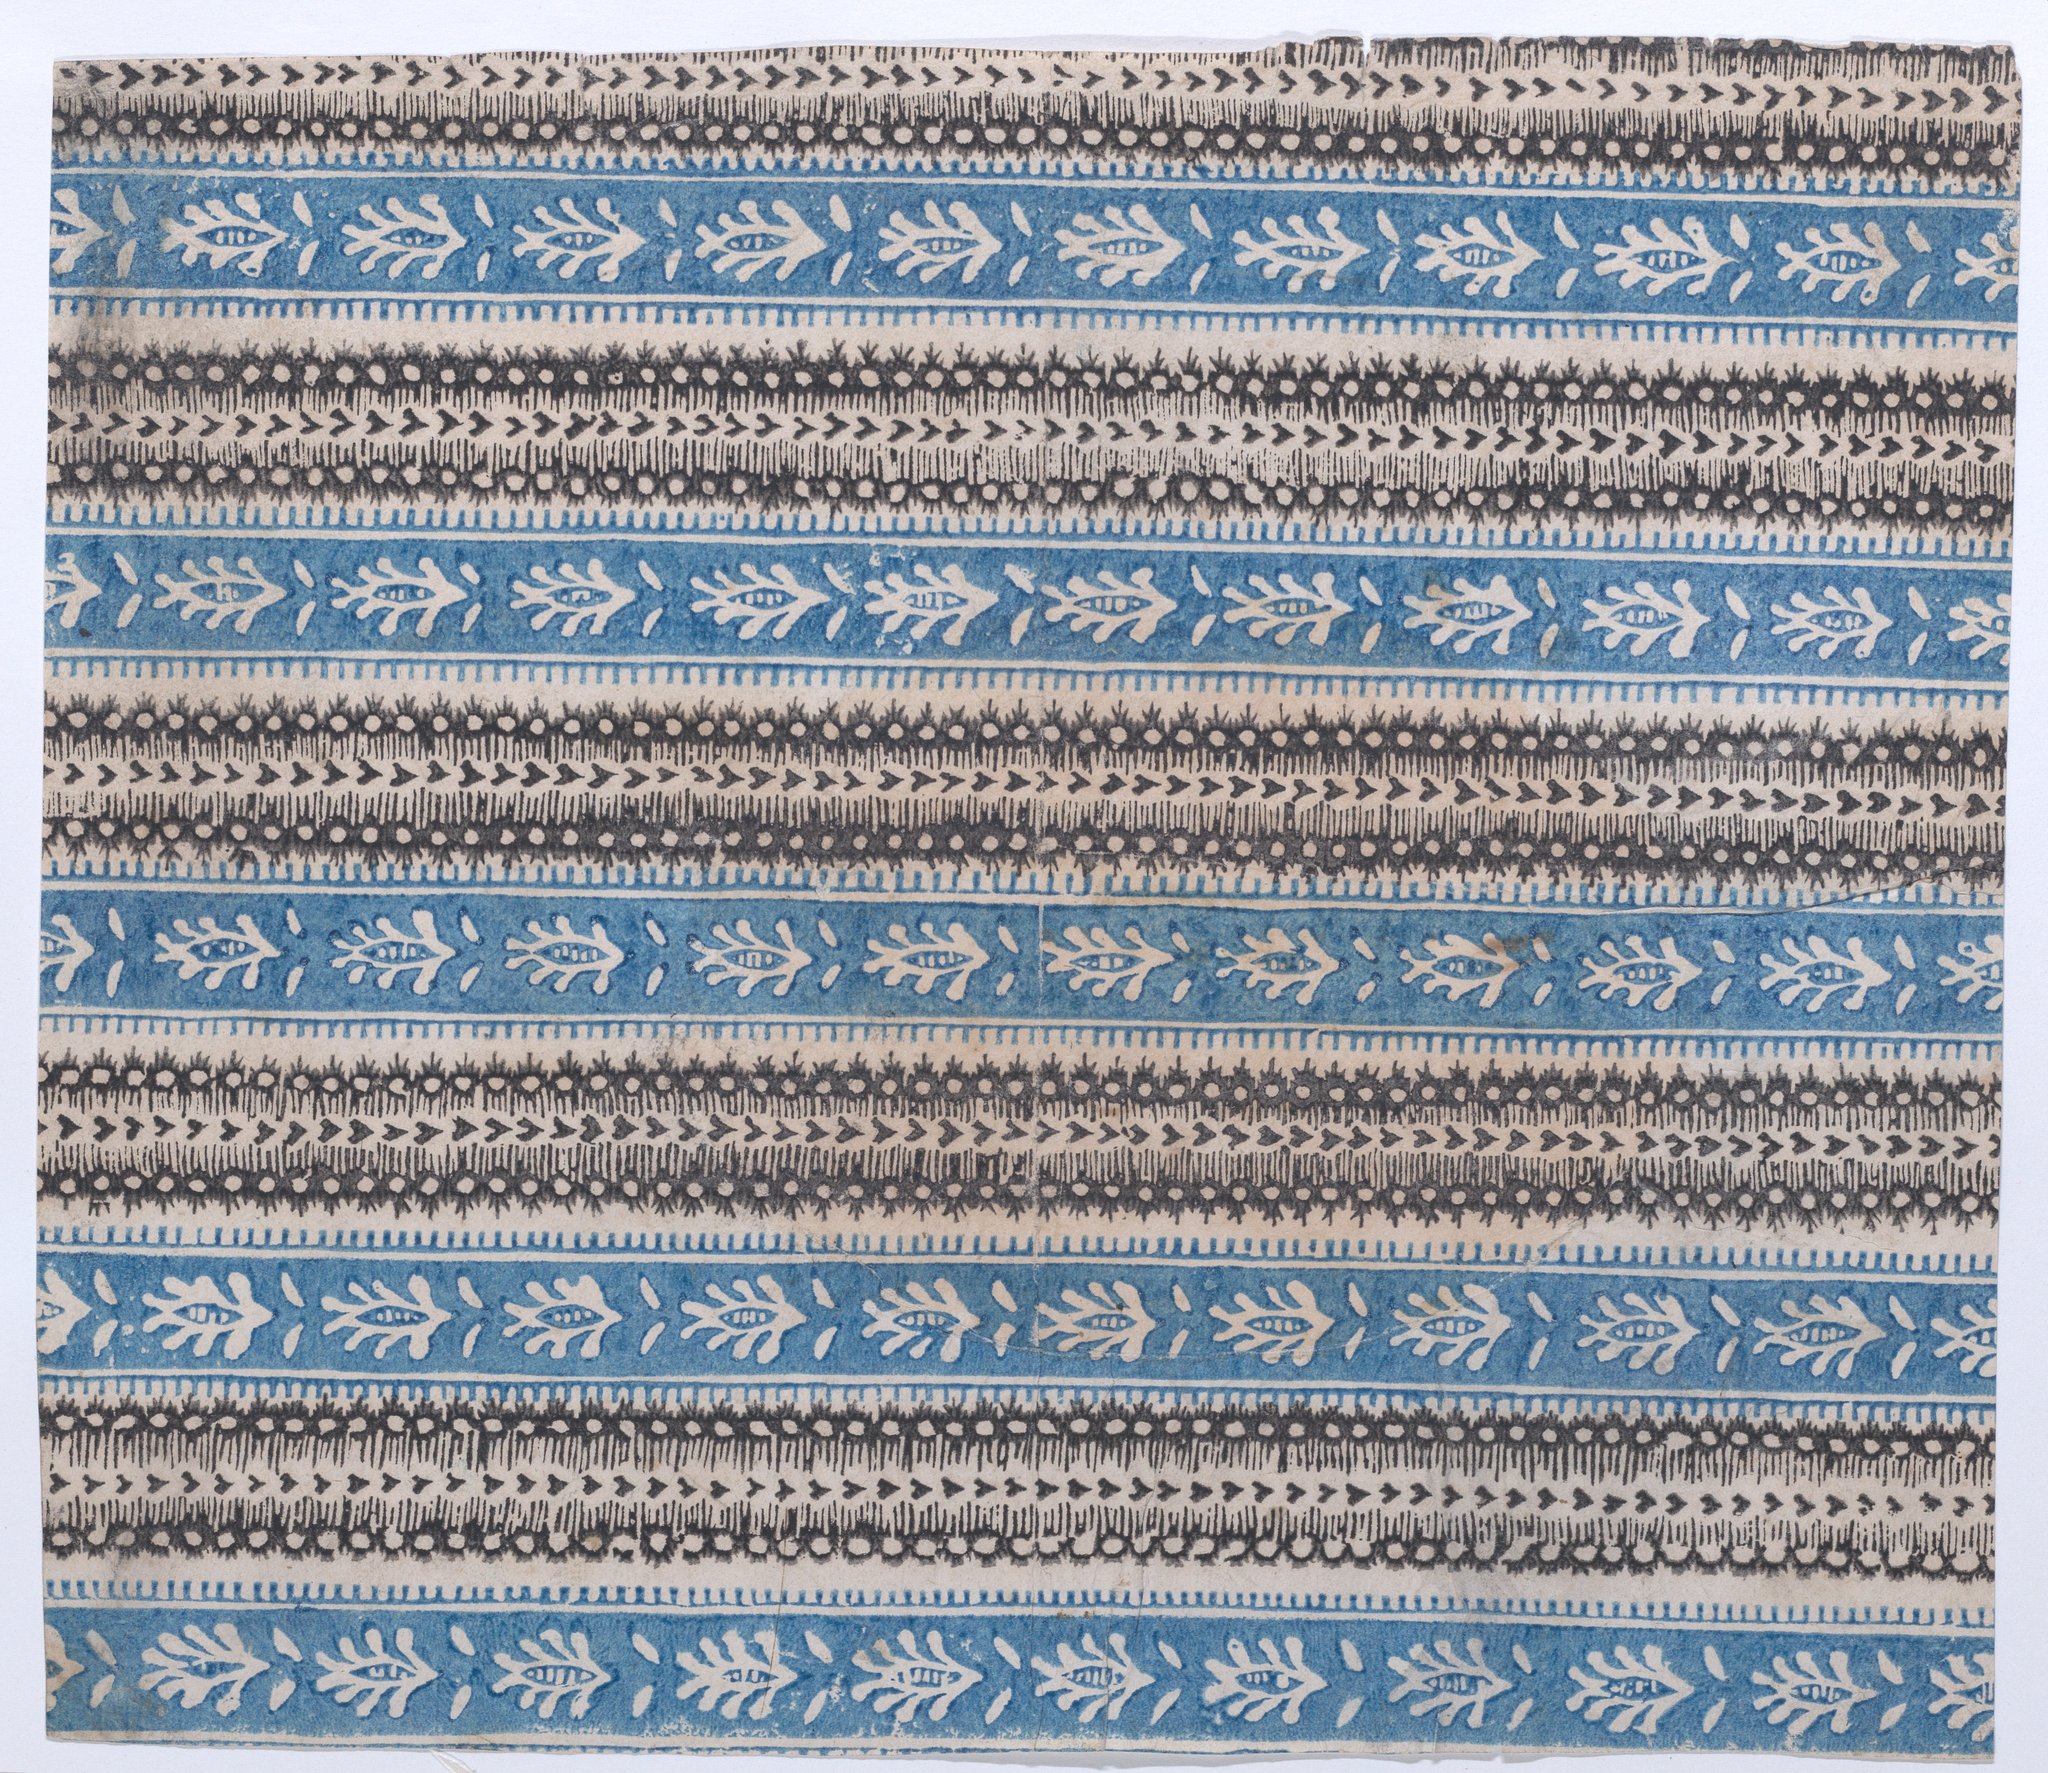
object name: print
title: Sheet with five borders with blue and black abstract patterns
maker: Anonymous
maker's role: artist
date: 1801-1900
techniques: relief print